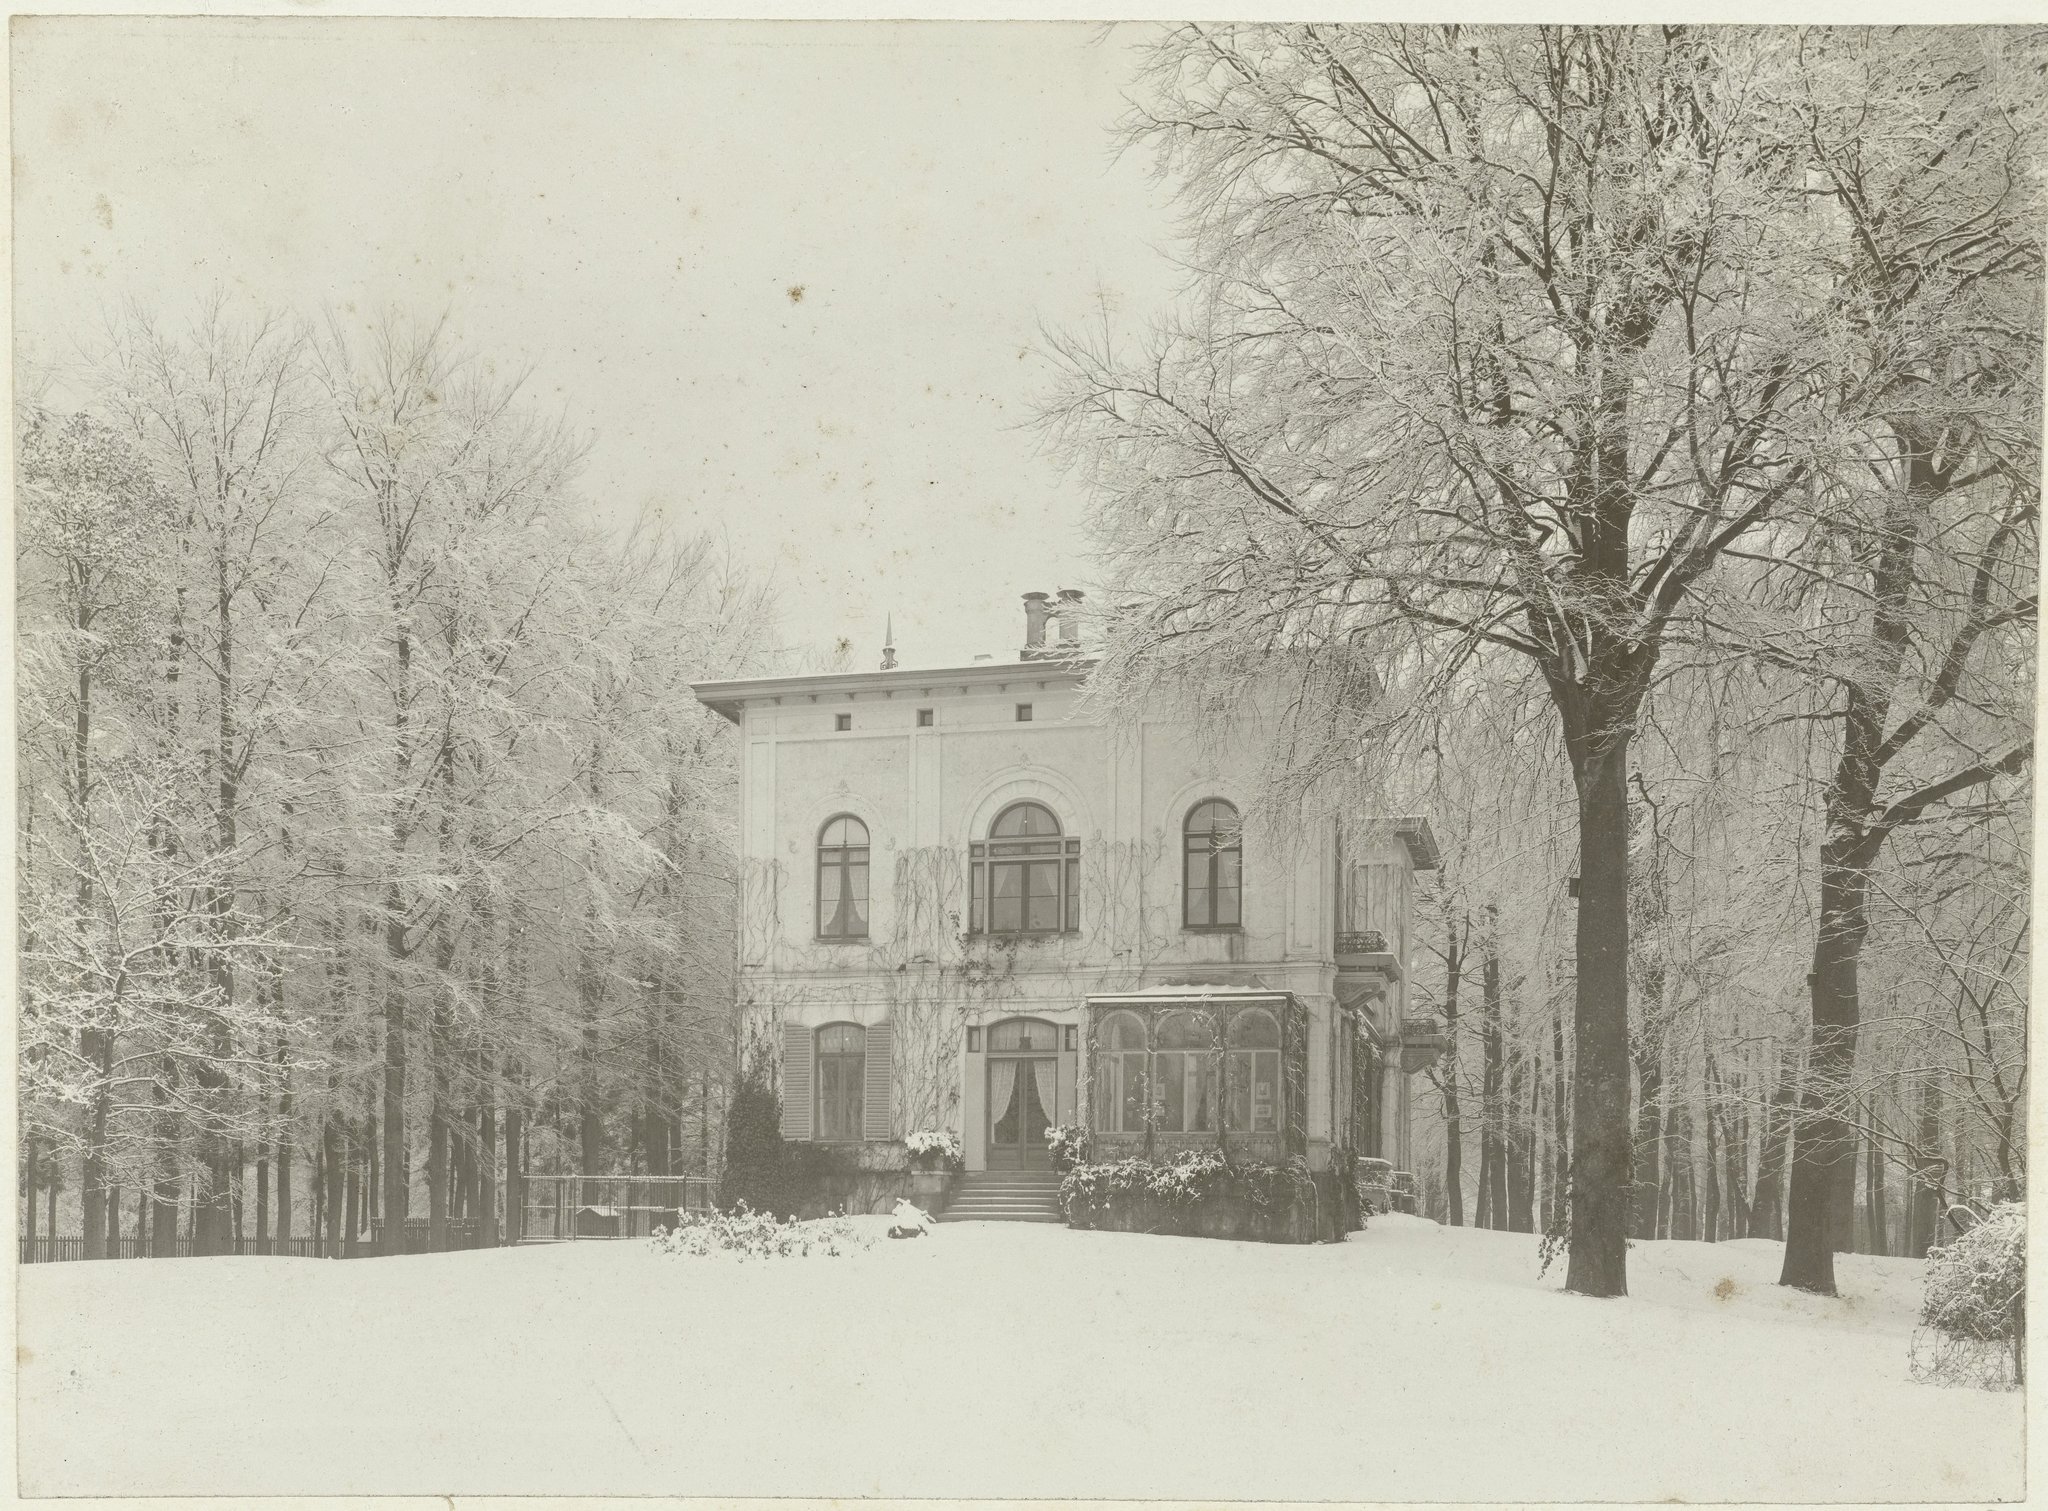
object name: photograph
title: Gezicht op landhuis De Wildbaan, Driebergen, met sneeuw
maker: henry pauw van wieldrecht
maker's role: fotograaf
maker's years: 1863-1912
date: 1903-1907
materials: paper, photographic support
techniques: gelatin silver print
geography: netherlands